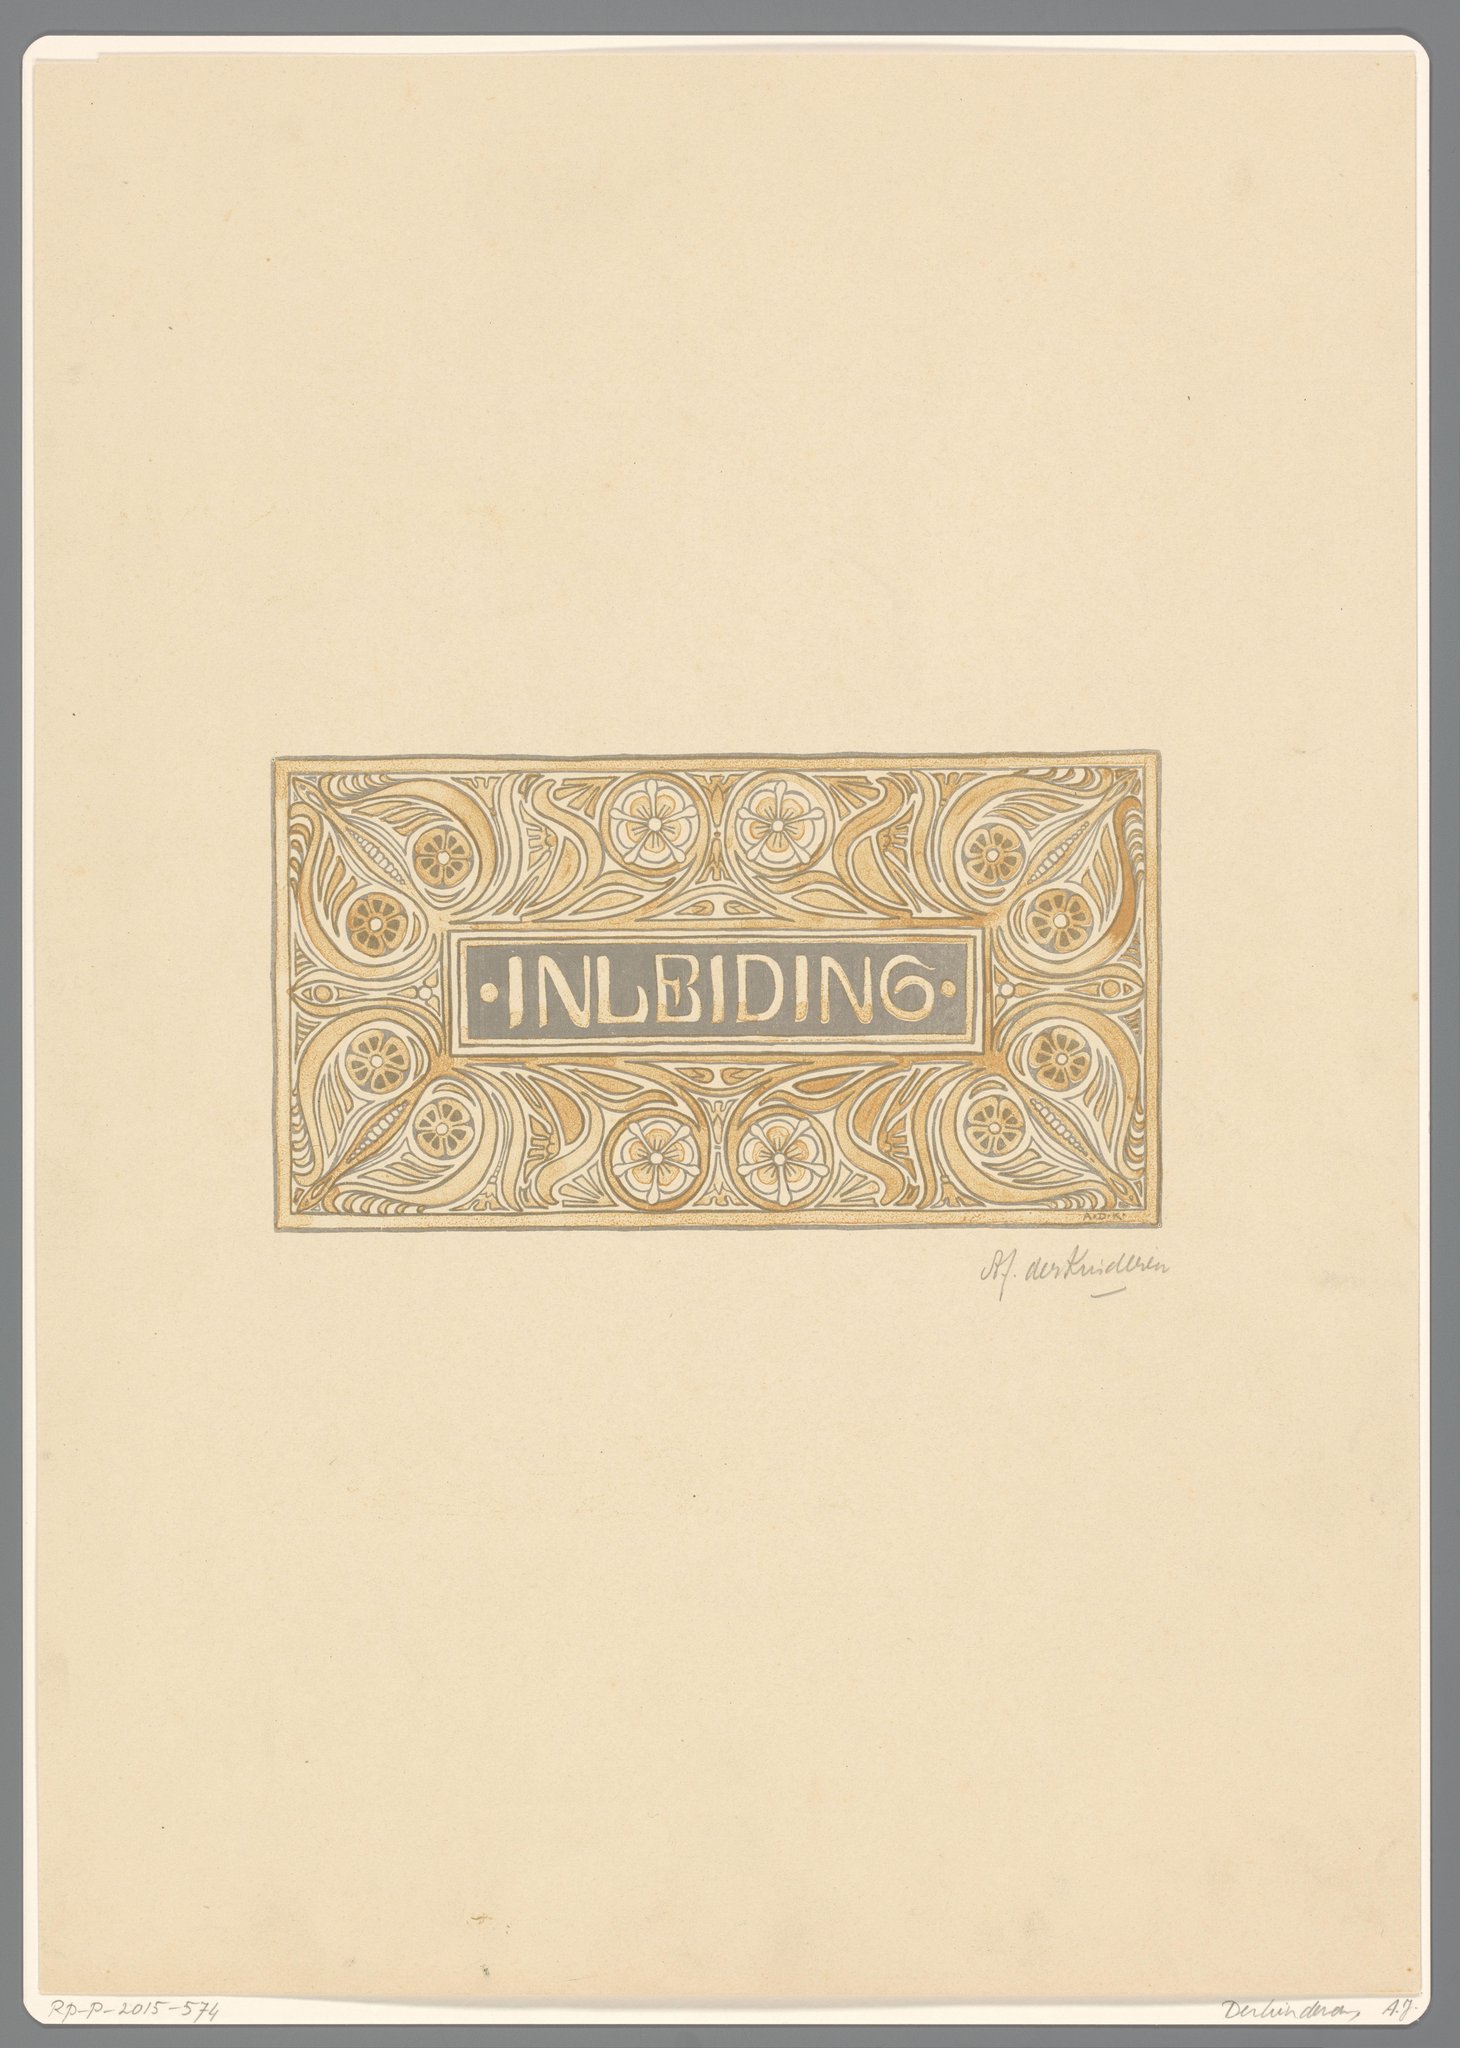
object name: print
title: Inleiding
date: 1894-1901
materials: paper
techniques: lithograph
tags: plants; vegetation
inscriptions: collector's mark: Lugt 2233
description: Prent gebruikt voor: Vondel, Joost van den. Gysbreght van Aemstel. Haarlem: Erven F. Bohn, 1894-1901. De voorstelling is door Tresling & Comp. op steen overgebracht.